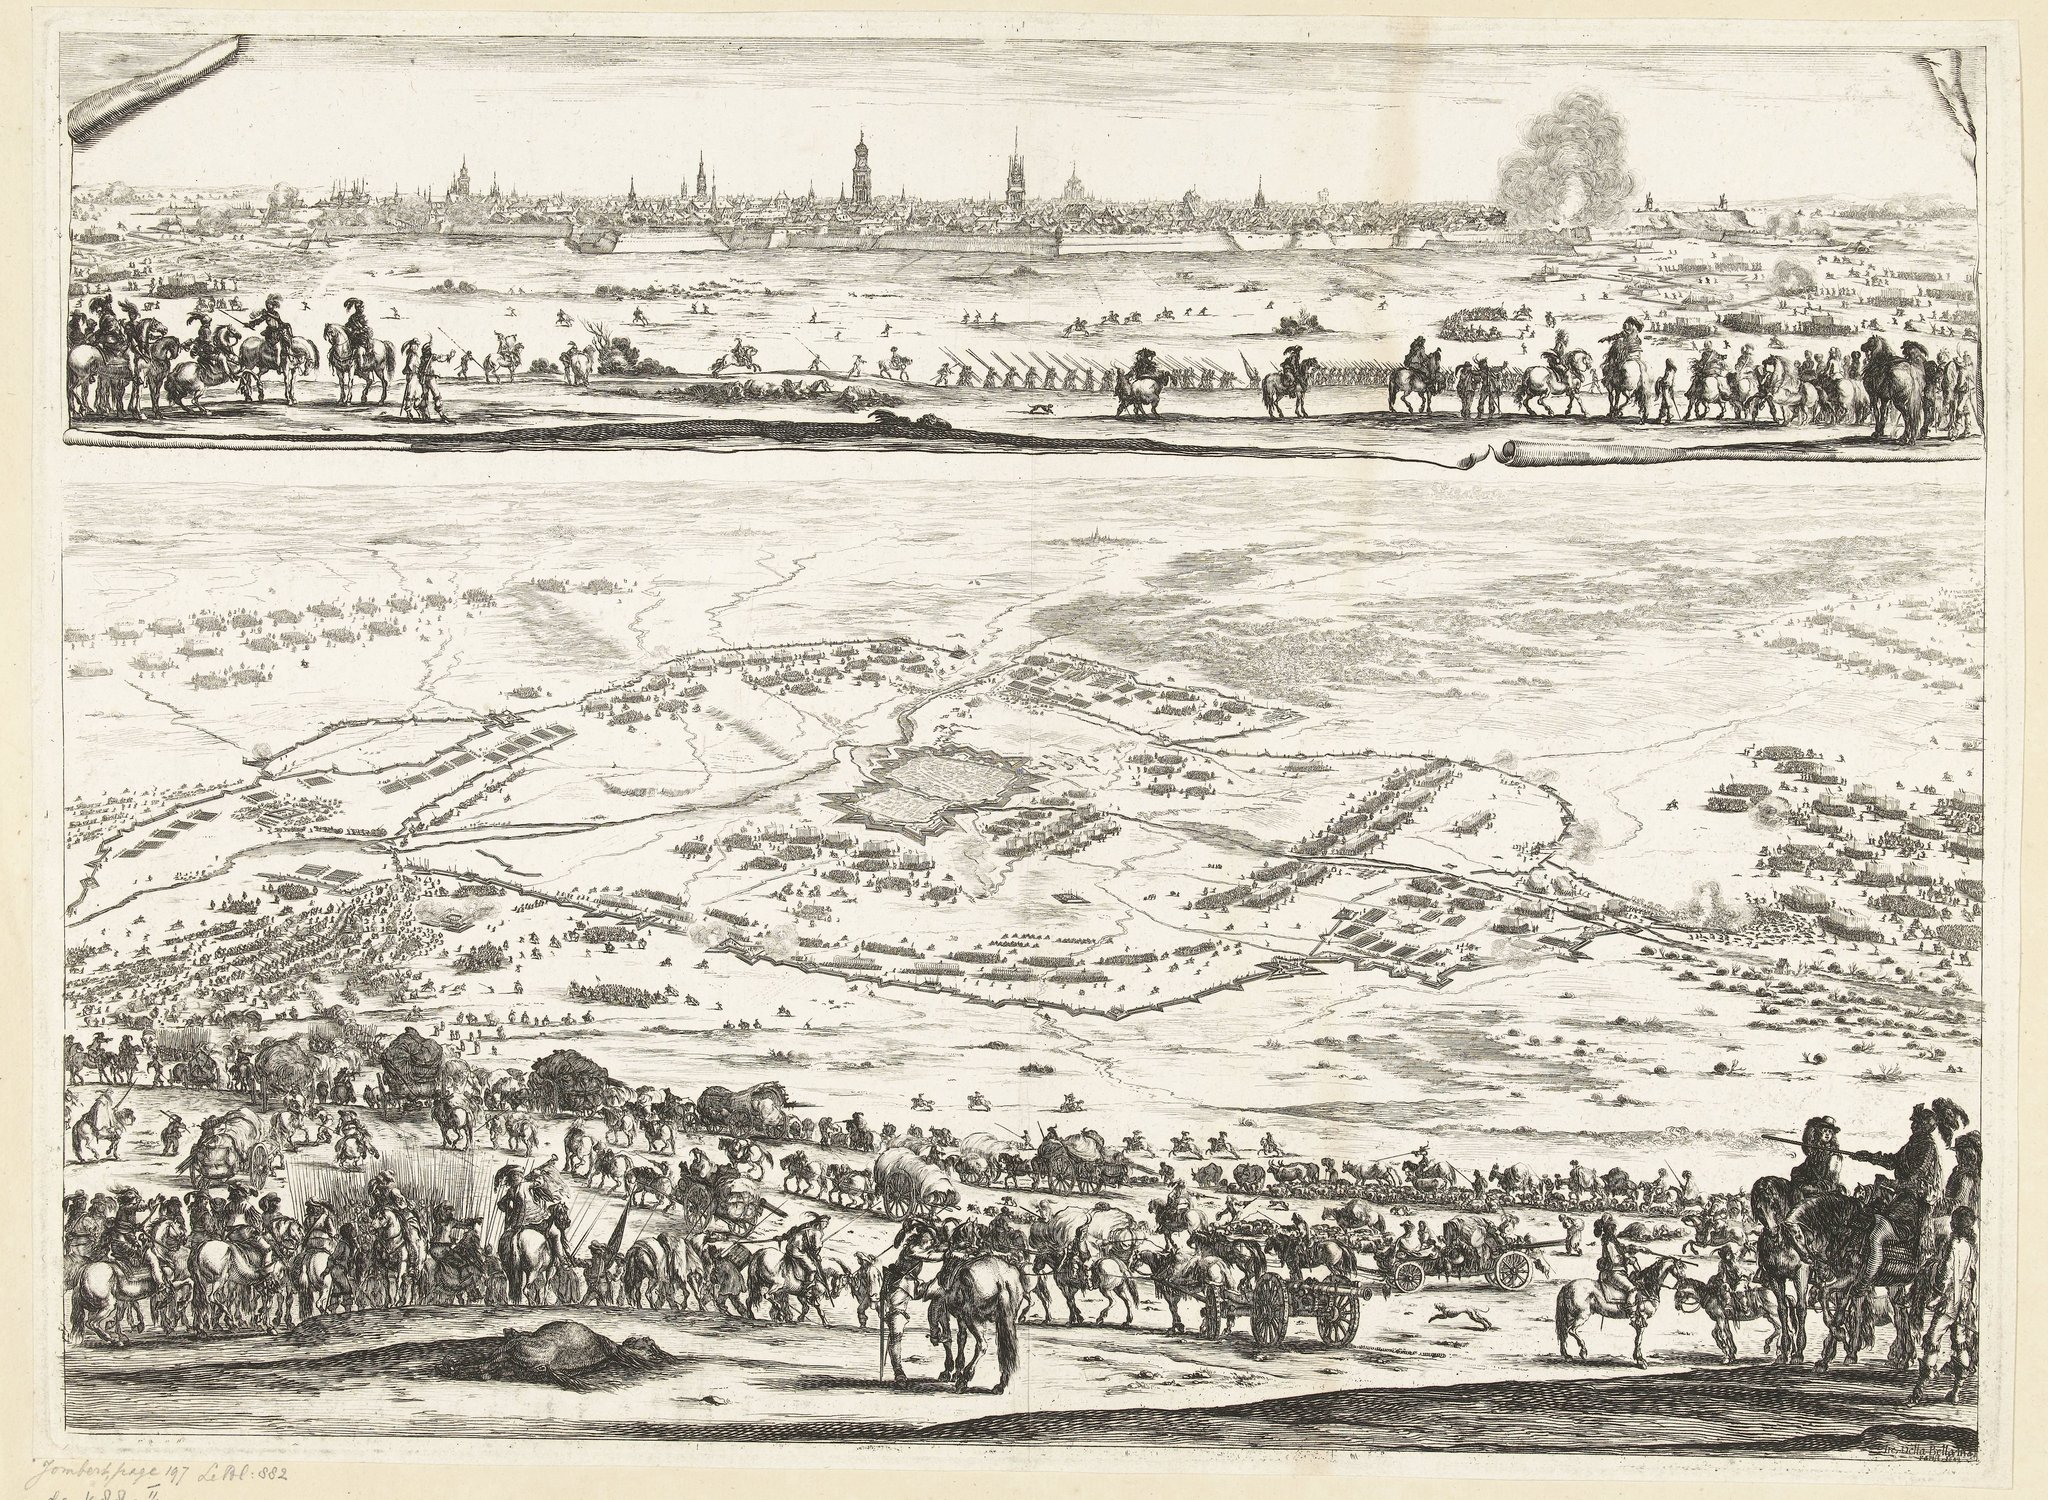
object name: print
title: Beleg van Arras, 1640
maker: stefano della bella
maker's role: draughtsman, print maker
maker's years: 1610-1664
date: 1641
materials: paper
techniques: etching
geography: paris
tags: siege, position war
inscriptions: collector's mark: Lugt 240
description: Blad met twee voorstellingen van het beleg van Arras (Atrecht) door de Fransen, vanaf 13 juli 1640. Bovenaan op een stuk papier het profiel van de stad met op de voorgrond de Franse troepen. Onder een grotere plan van het beleg met op de voorgrond een Frans konvooi met goederenwagens.